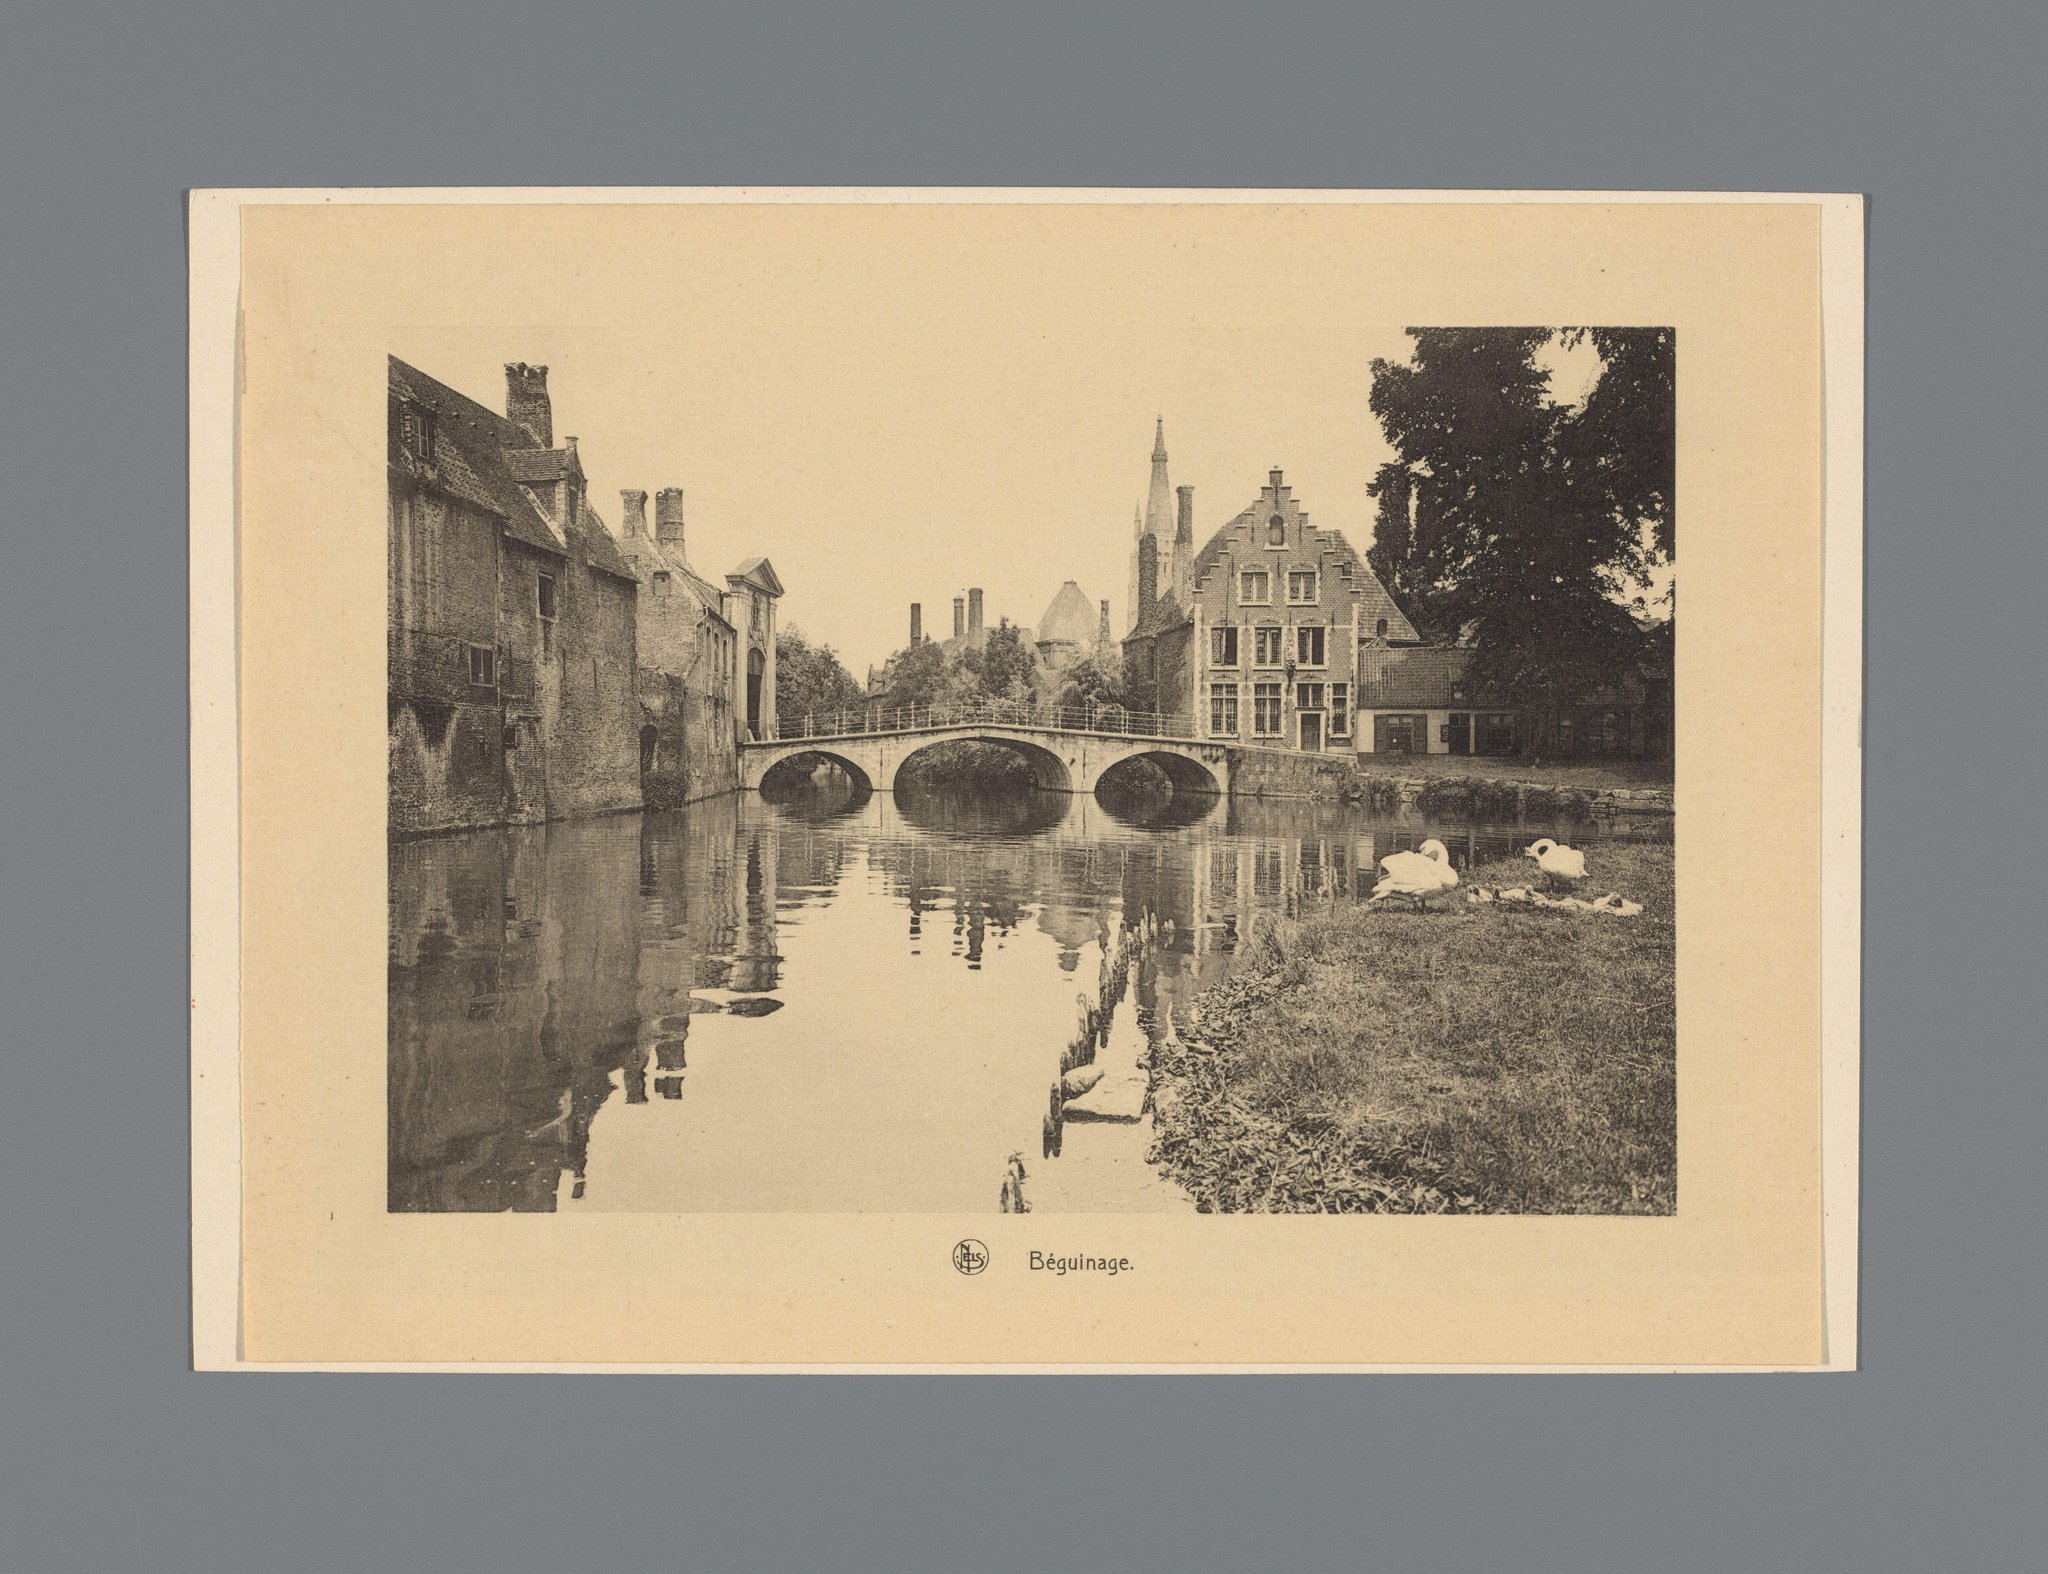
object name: photograph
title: Brugge. Béguinage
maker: Anonymous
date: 1860-1925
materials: photographic support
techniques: photograph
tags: bruges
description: Object is bevestigd aan RP-F-2015-13-308-2.